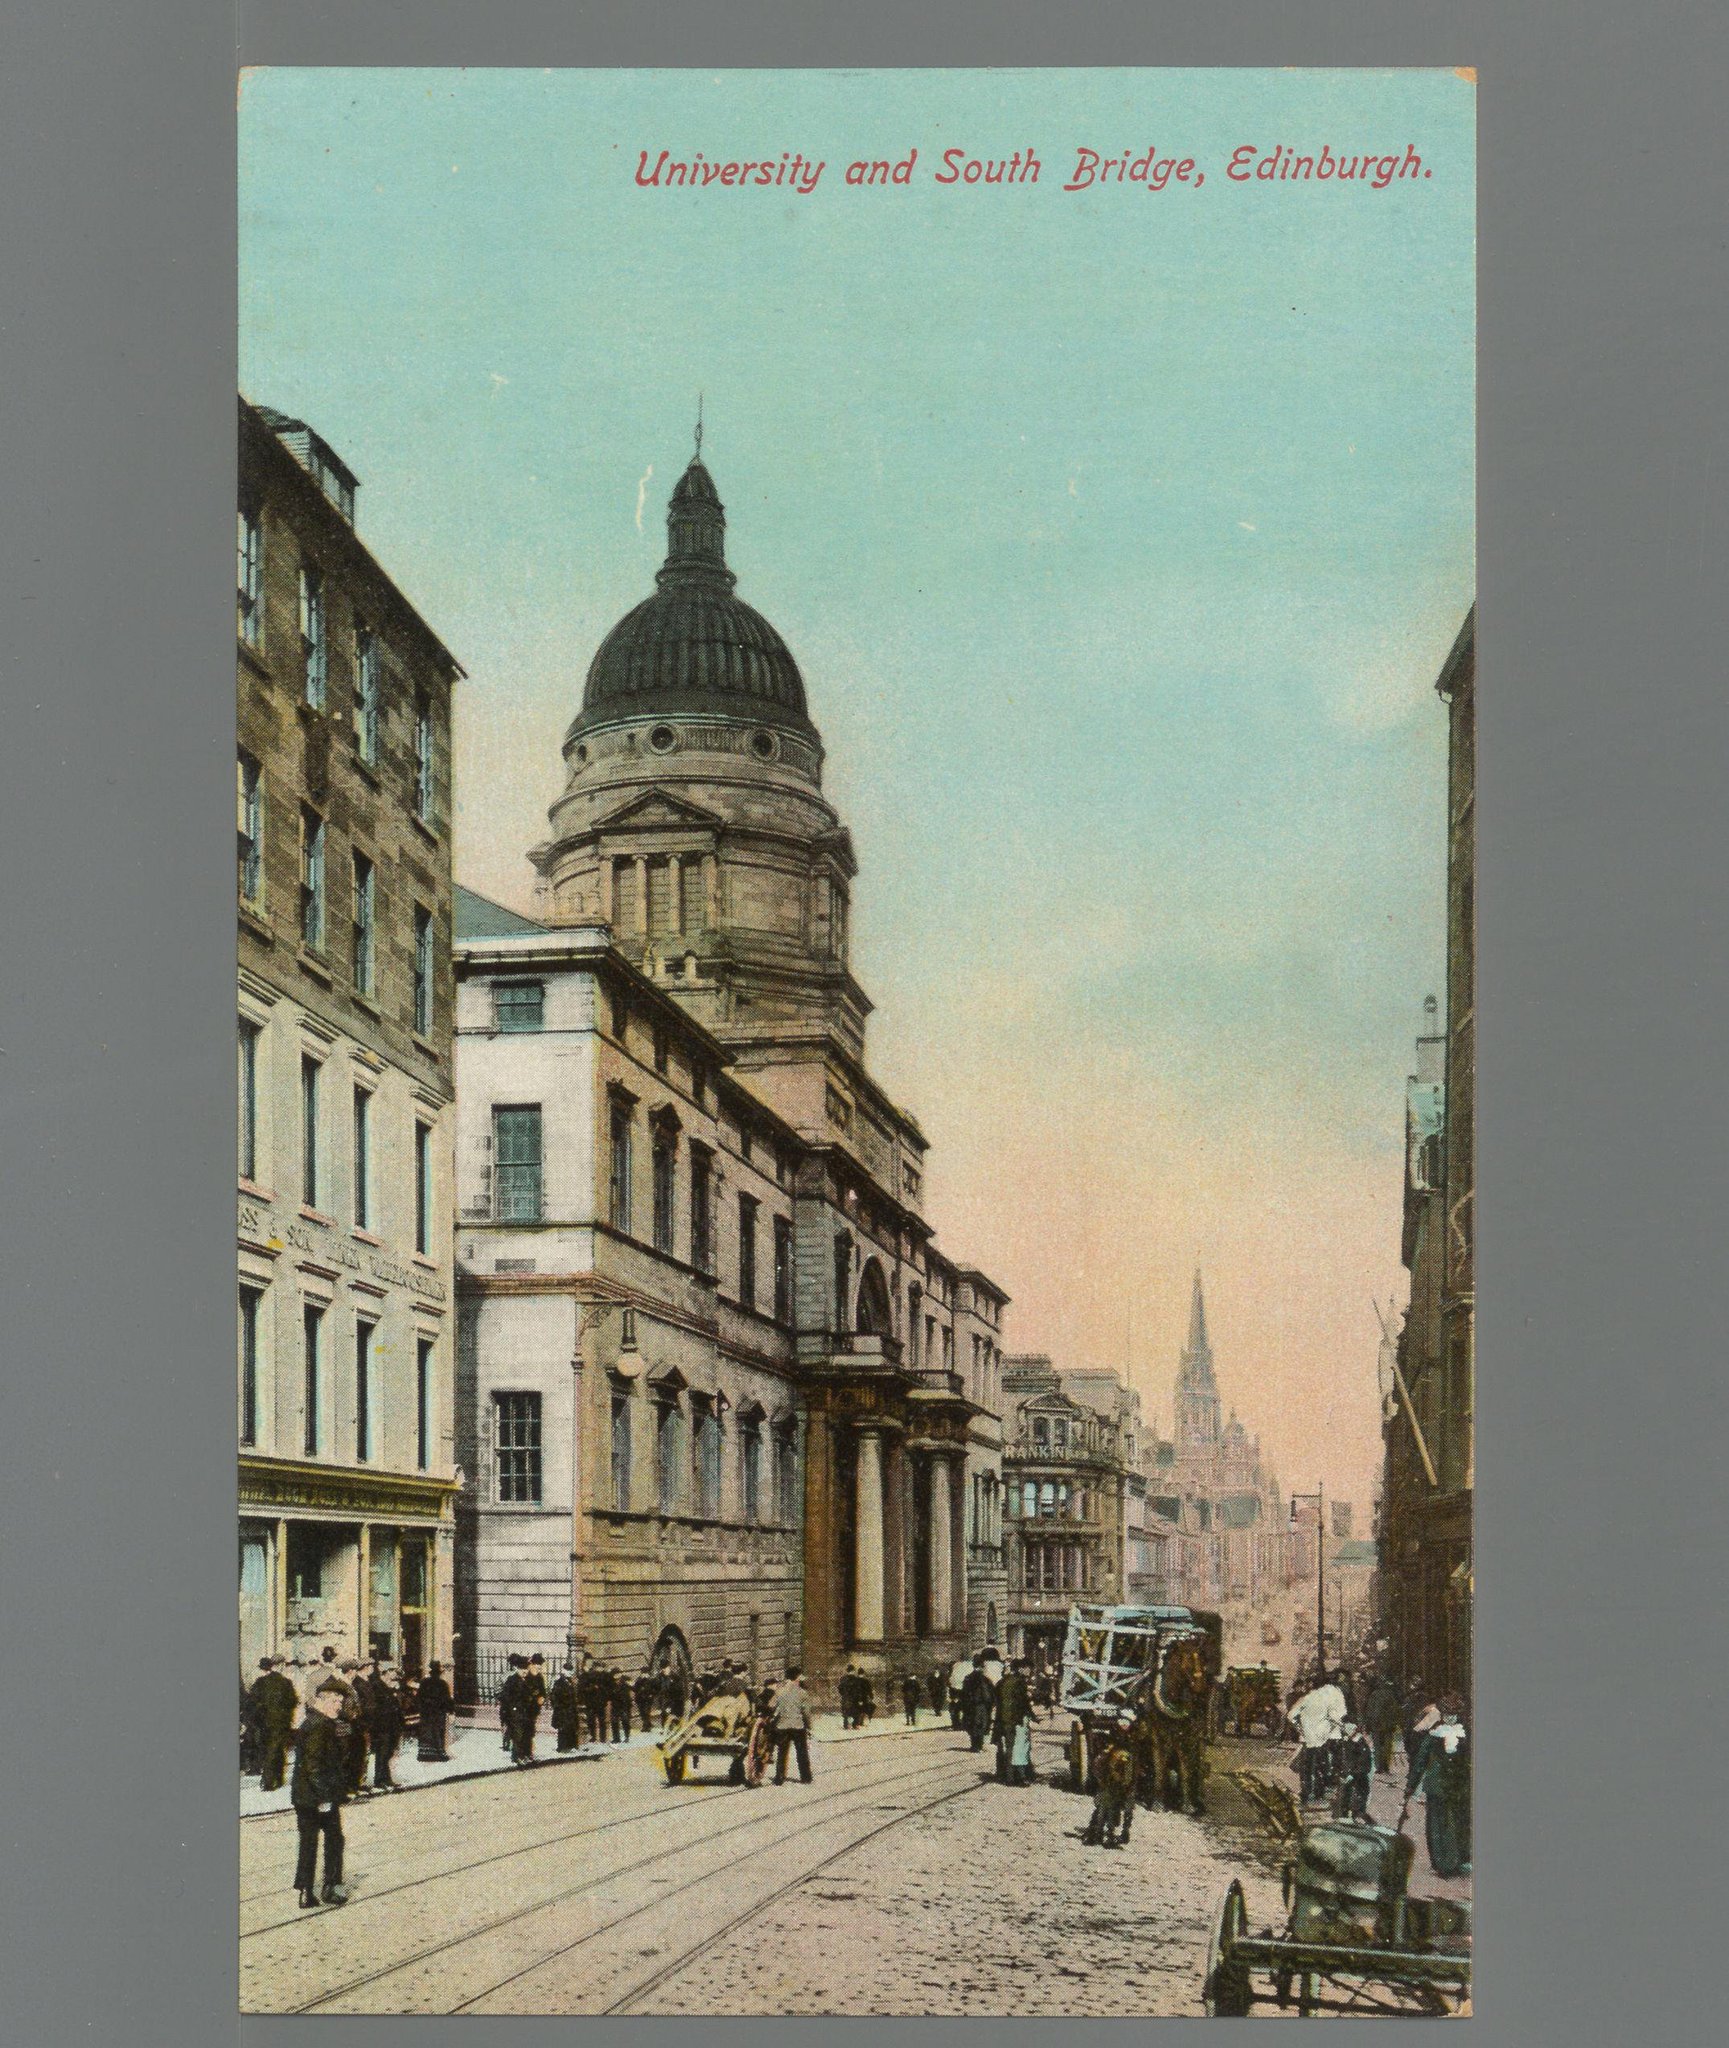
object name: photomechanical print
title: University and South Bridge, Edinburgh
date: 1902-1930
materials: cardboard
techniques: lithograph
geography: edinburgh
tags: university building, college, street